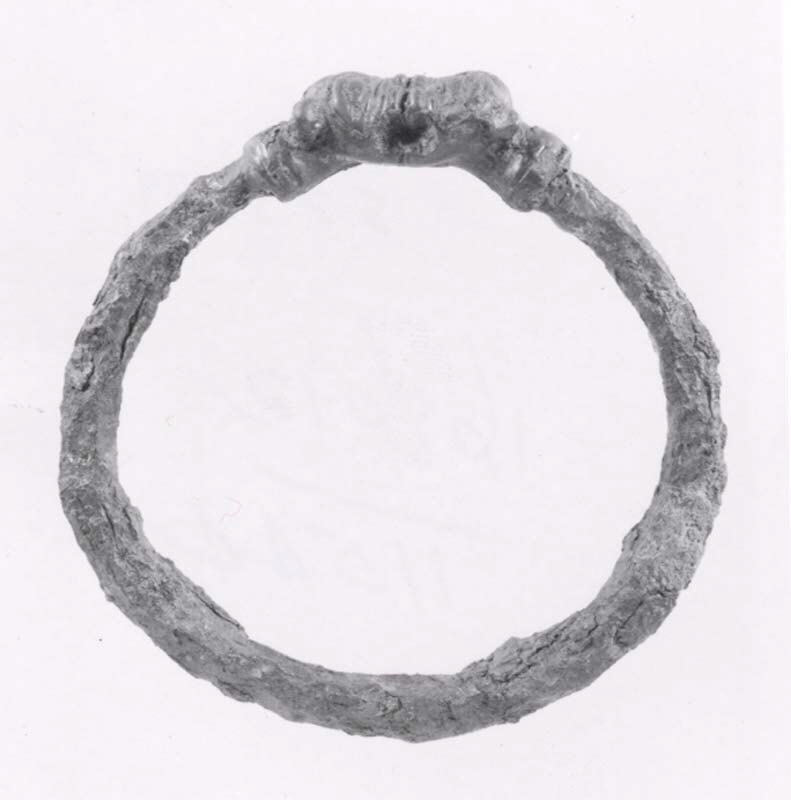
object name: bracelet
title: Bracelet or anklet with lion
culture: iranian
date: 800-601 BCE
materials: bronze, iron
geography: iran, probably from luristan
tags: lions